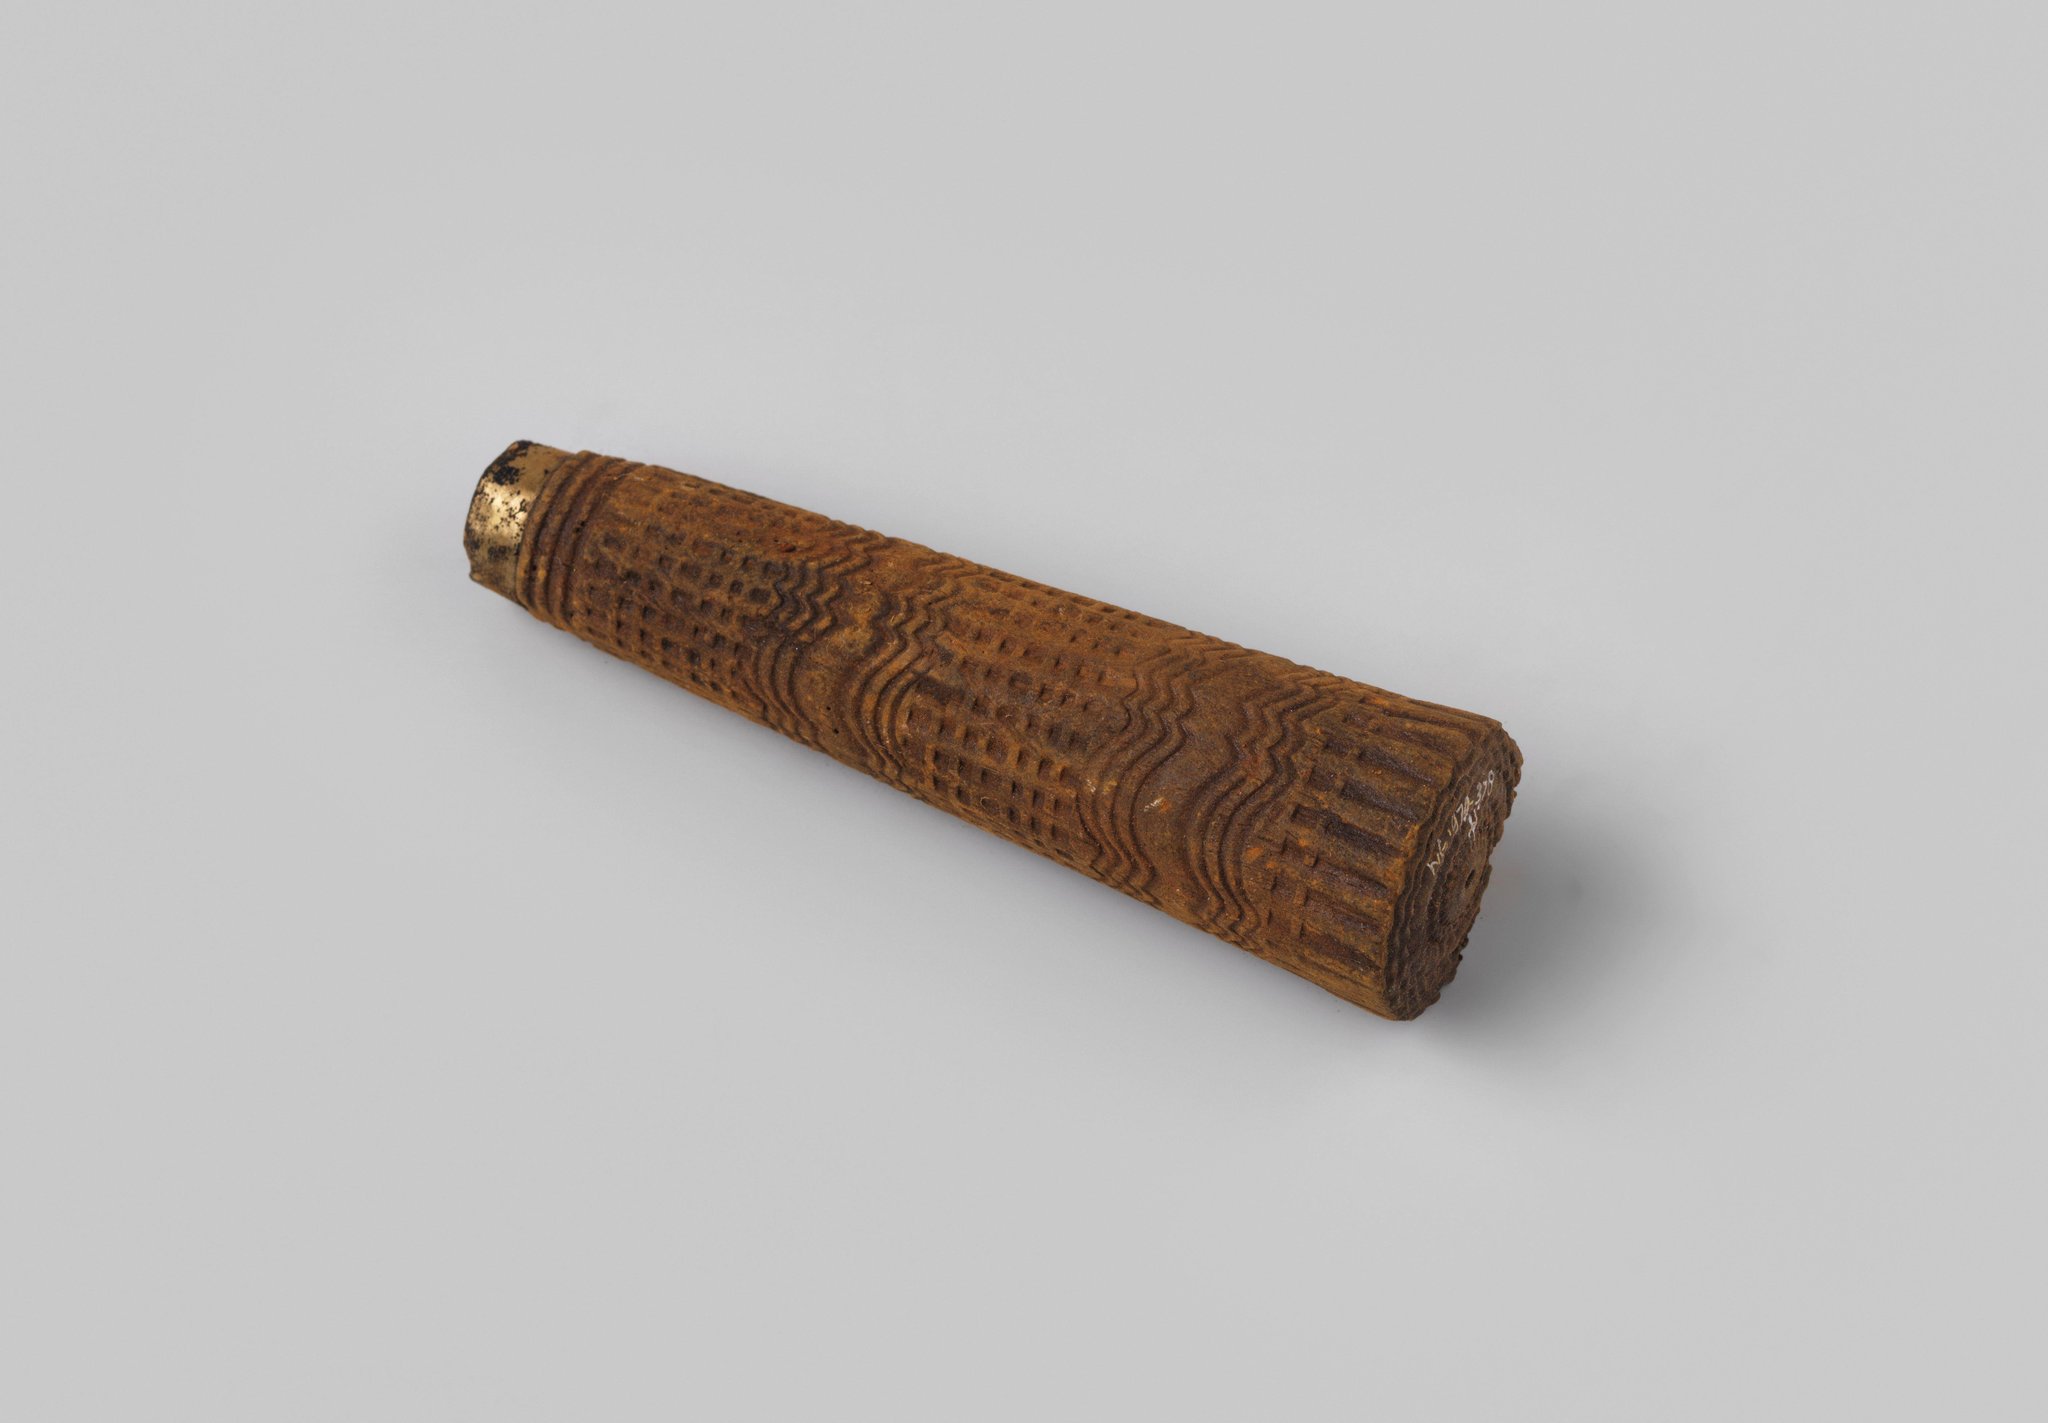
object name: knife handle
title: Messenheft uit het wrak van de Oost-Indiëvaarder Hollandia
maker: Anonymous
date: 1700-1743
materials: wood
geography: netherlands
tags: verenigde oostindische compagnie, hollandia (schip), annet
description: Knife, handle, cylindrical: tapering; id. NG 1979-403H, ferrules id. NG 1980-27H426.